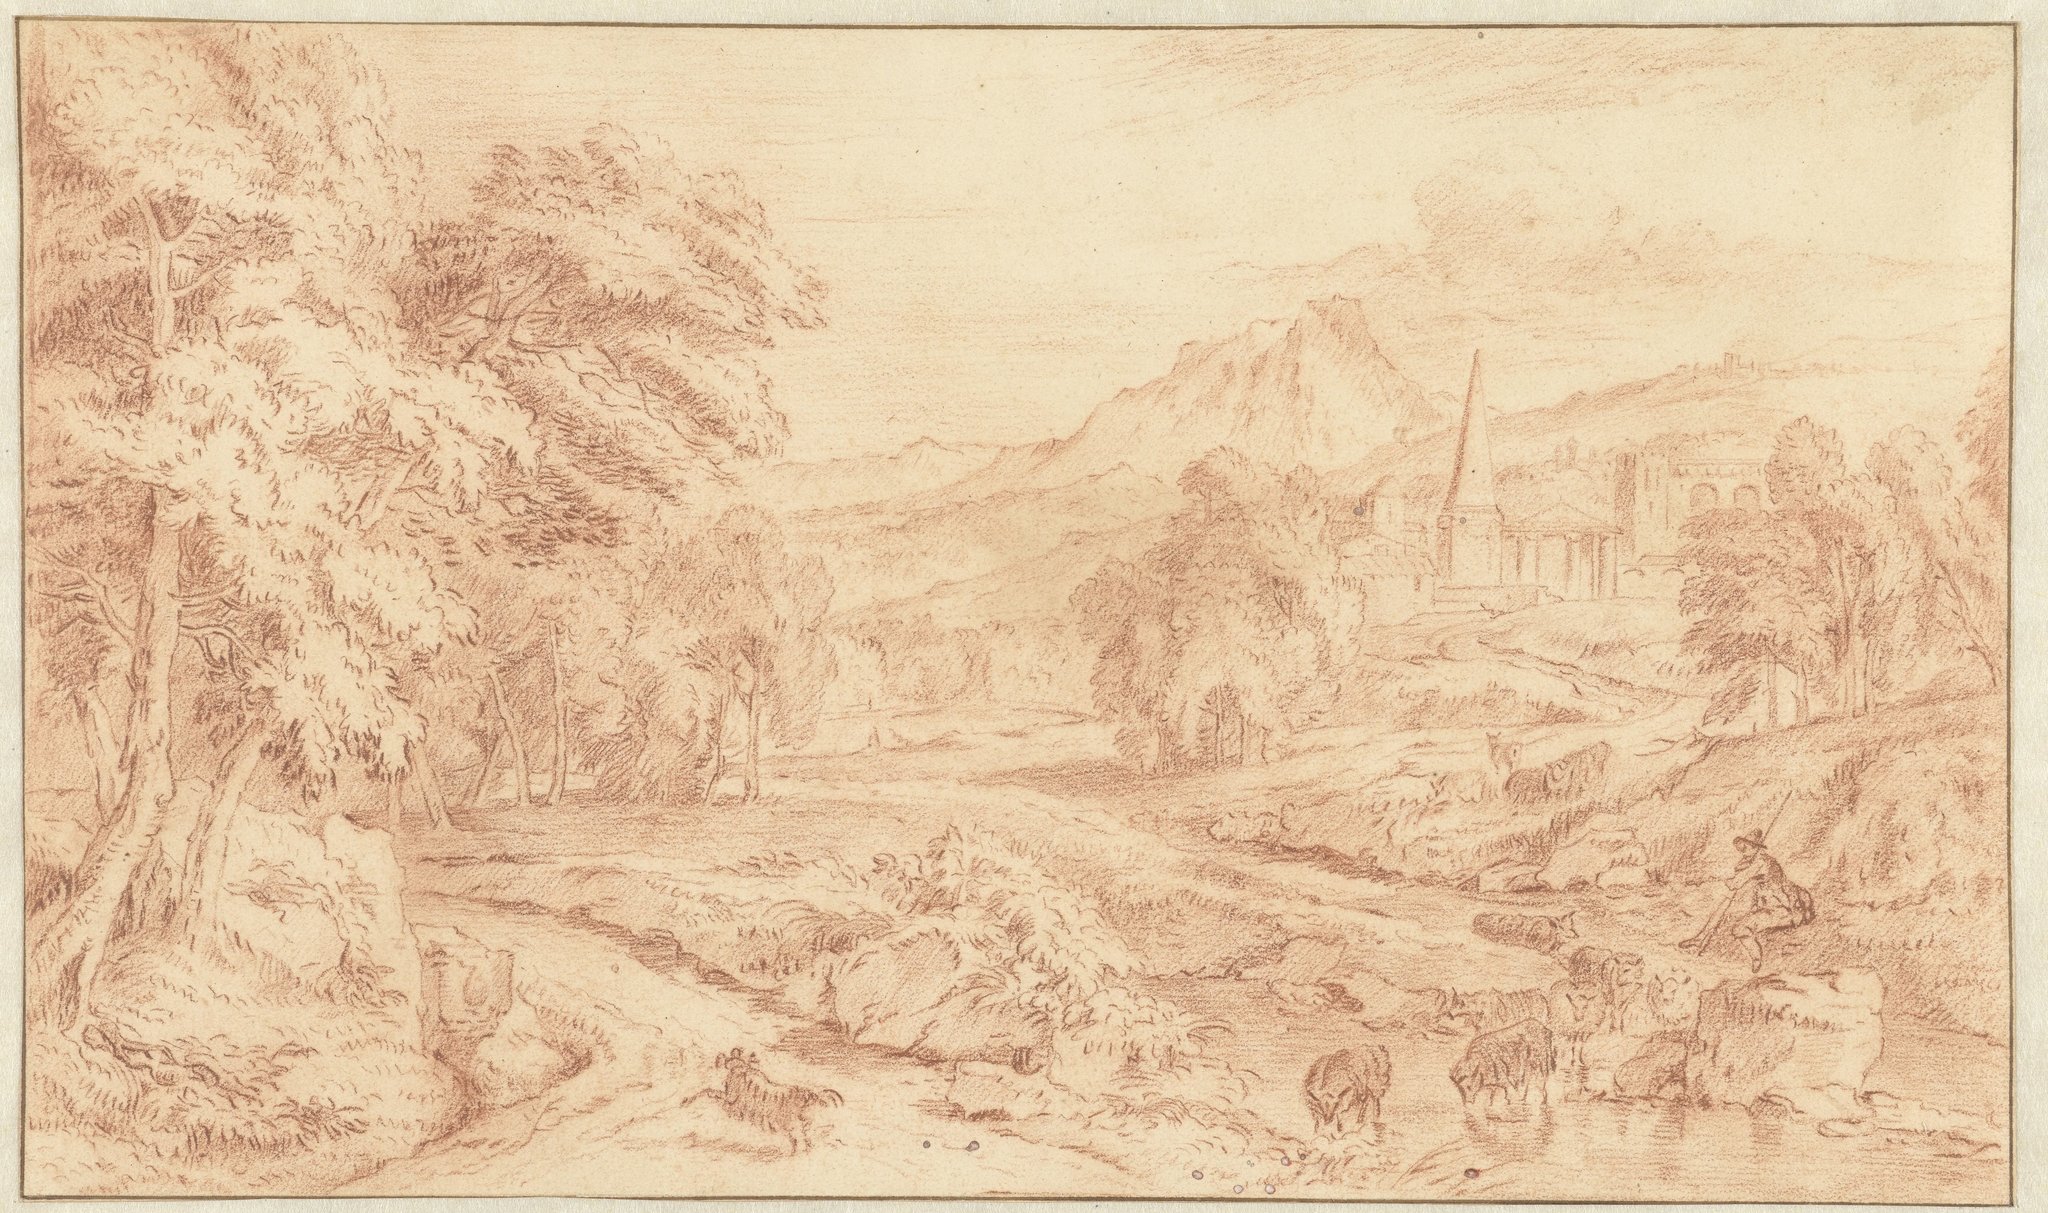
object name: drawing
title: Italianate Landscape with a Shepherd and his Flock by the Water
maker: Anonymous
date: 1650-1725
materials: chalk, paper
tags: herding, herdsman, herdswoman, shepherd, shepherdess, cowherd, etc., landscape with ruins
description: Italiaans landschap met klassieke ruïnes en een schaapherder bij een voorde.